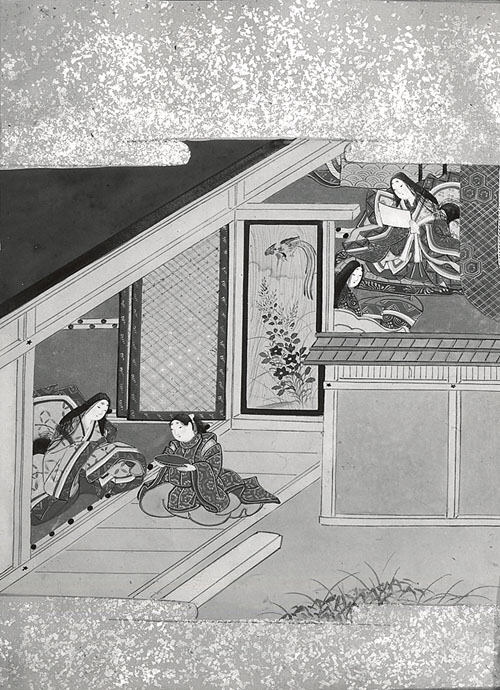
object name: book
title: Tales of Ise (Ise monogatari)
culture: japanese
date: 1701-1800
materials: gold, ink, paper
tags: men,women,horses